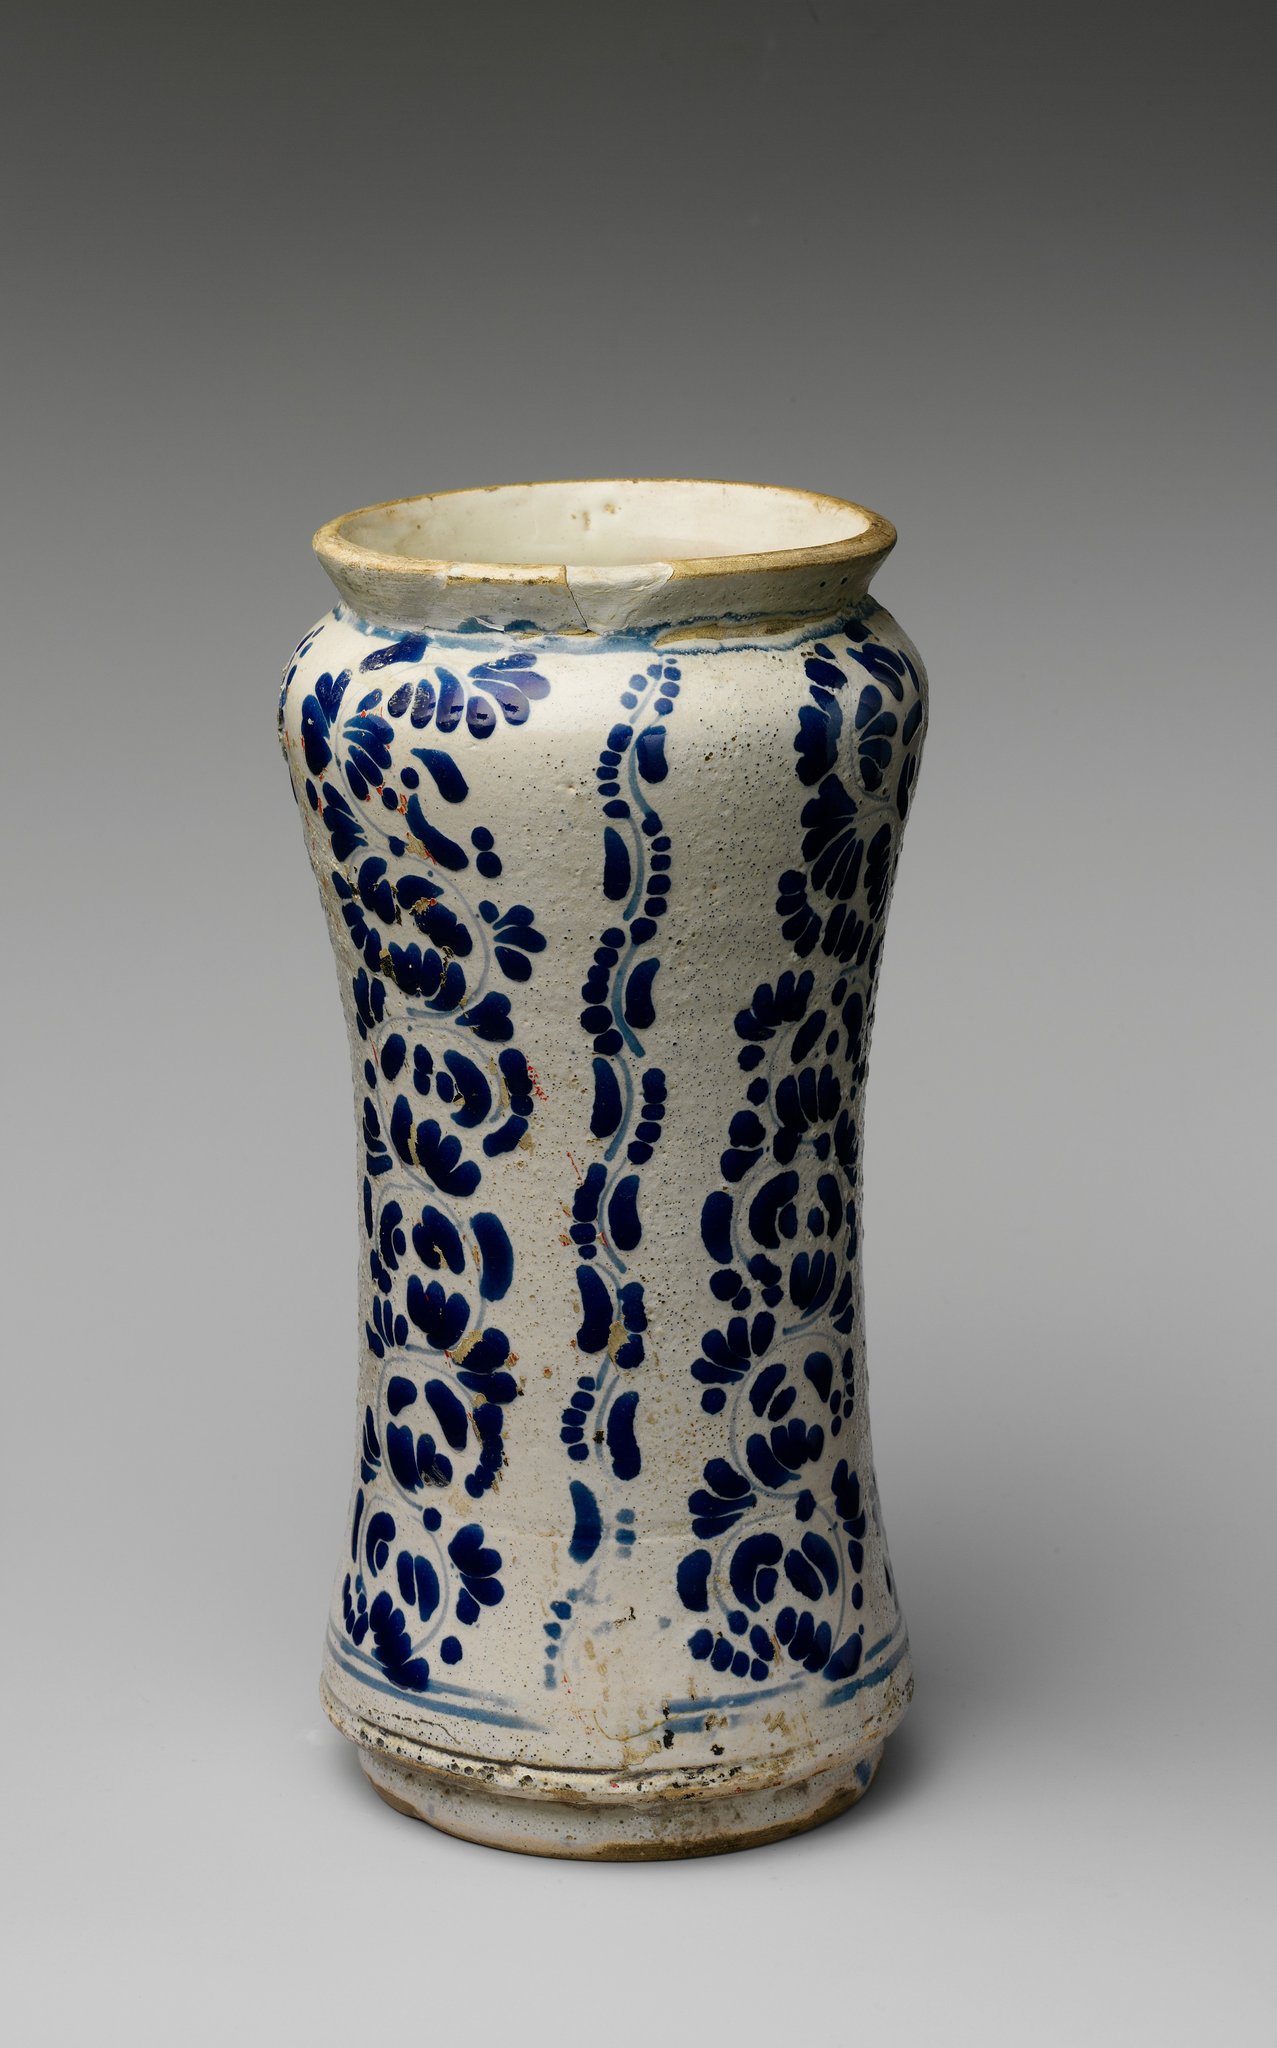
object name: apothecary jar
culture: mexican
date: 1750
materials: earthenware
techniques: glazing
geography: mexico